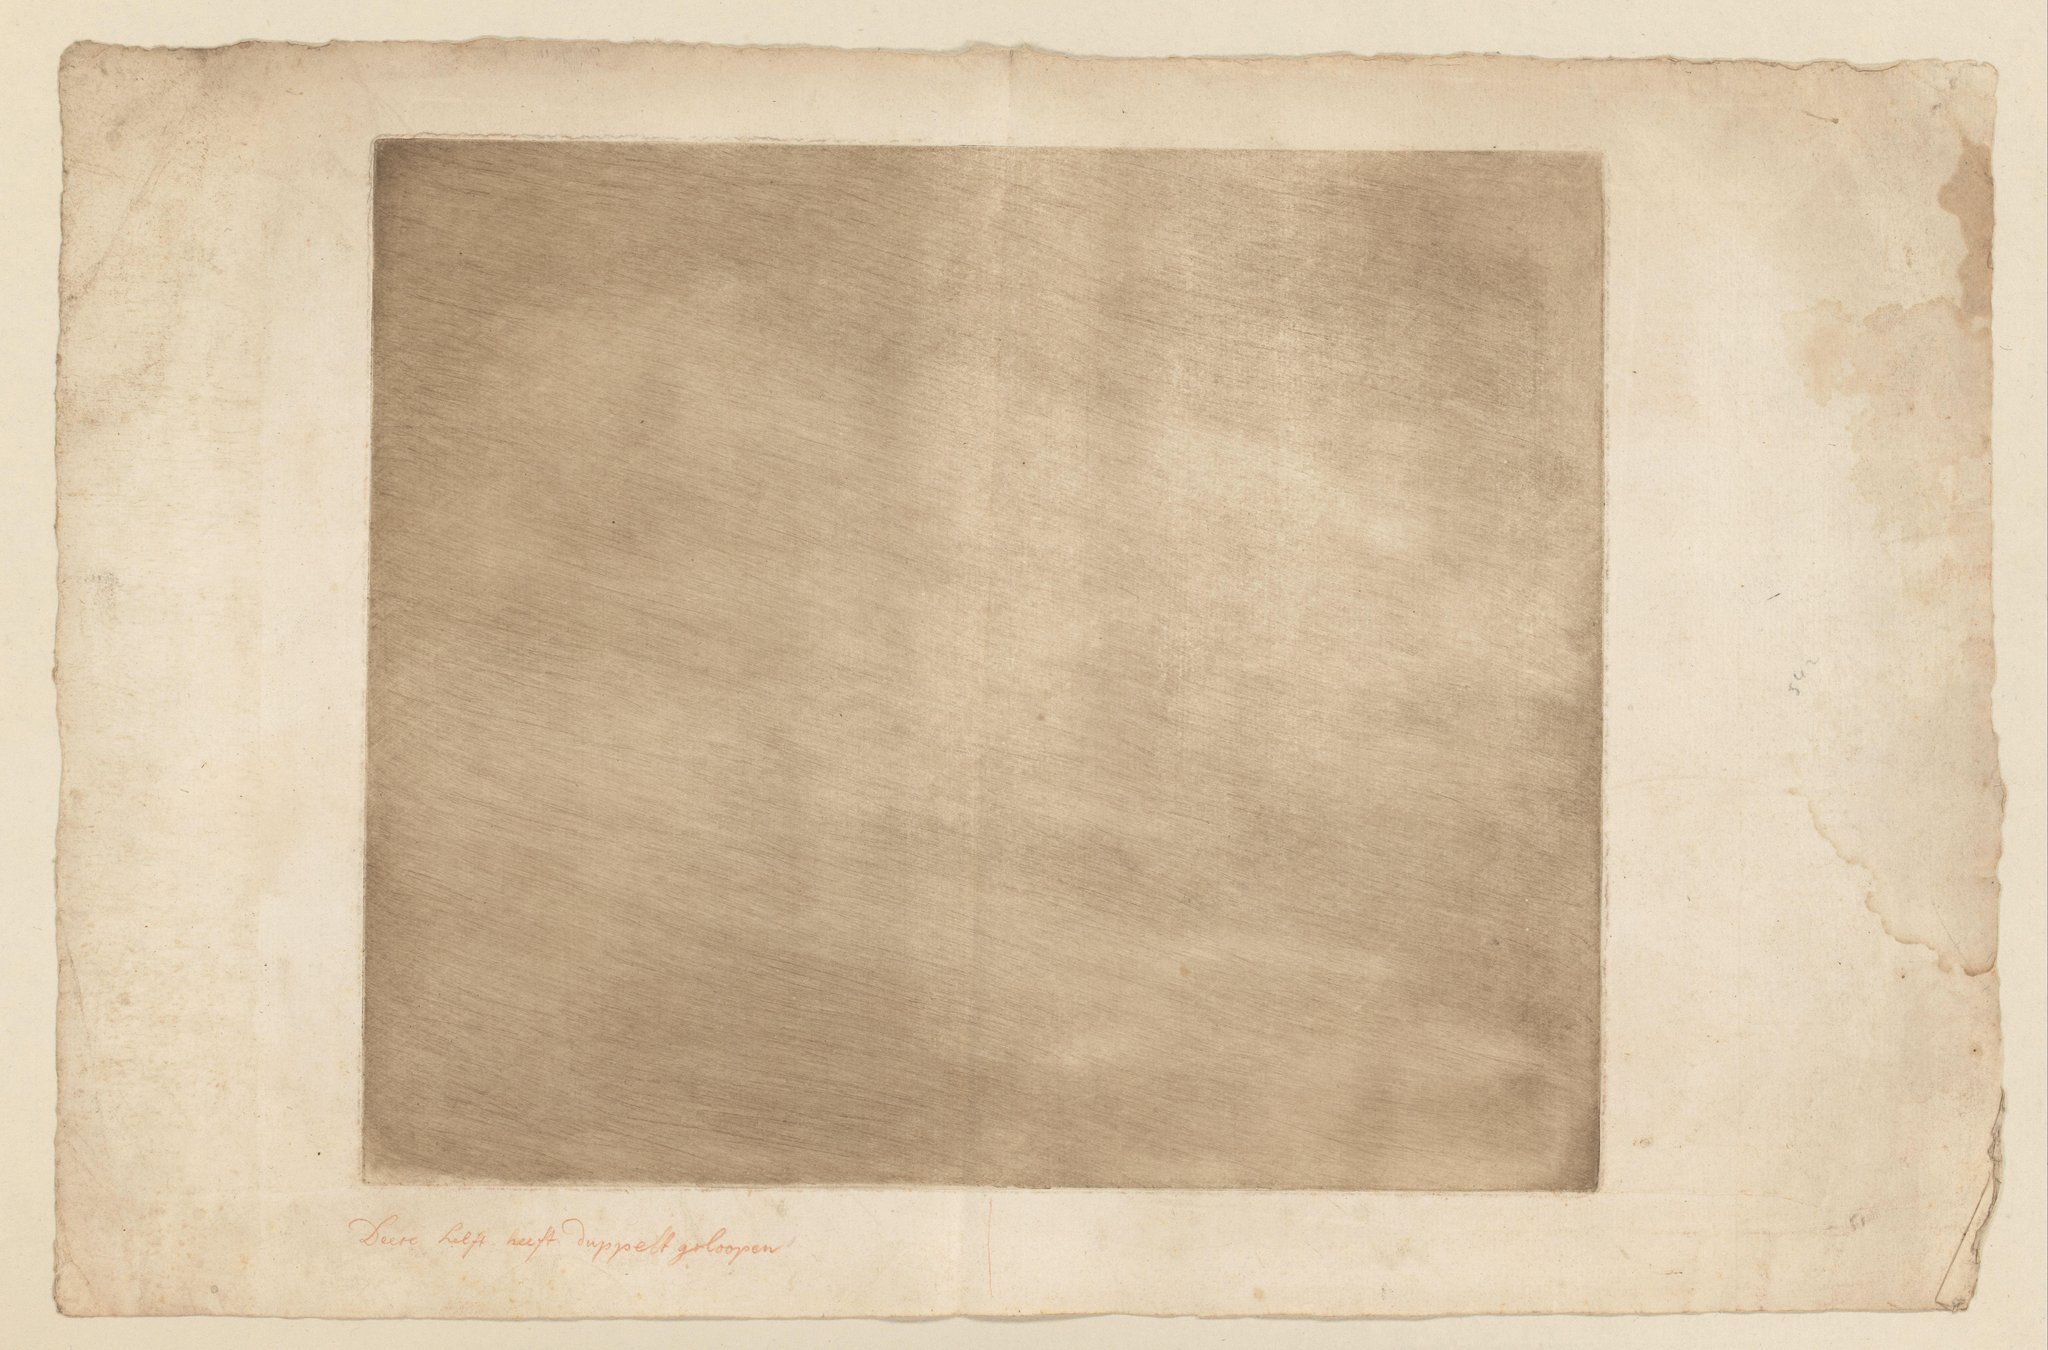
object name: print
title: Proef in egaal grijs/bruin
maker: cornelis ploos van amstel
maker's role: draughtsman, print maker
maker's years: 1726-1798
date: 1736-1798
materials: paper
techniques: intaglio, sanding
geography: amsterdam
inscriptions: inscription: ‘Deese helft heeft duppelt geloopen’